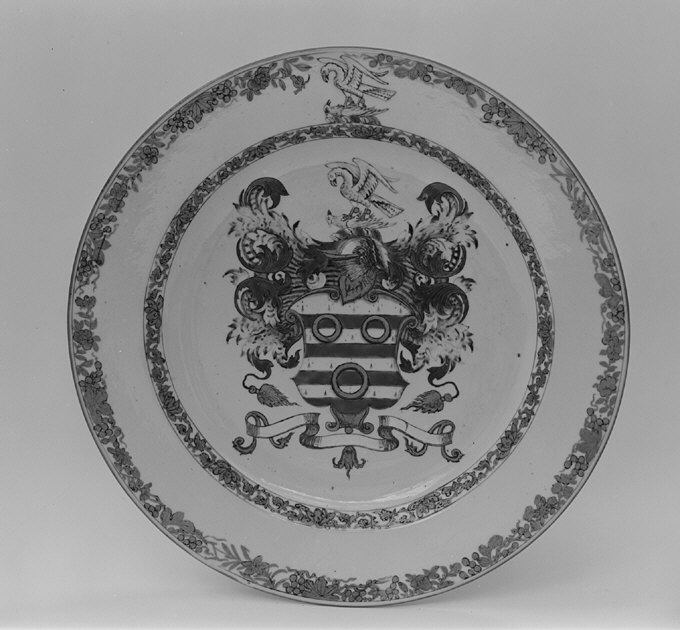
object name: plate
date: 1740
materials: hard paste porcelain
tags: birds,coat of arms